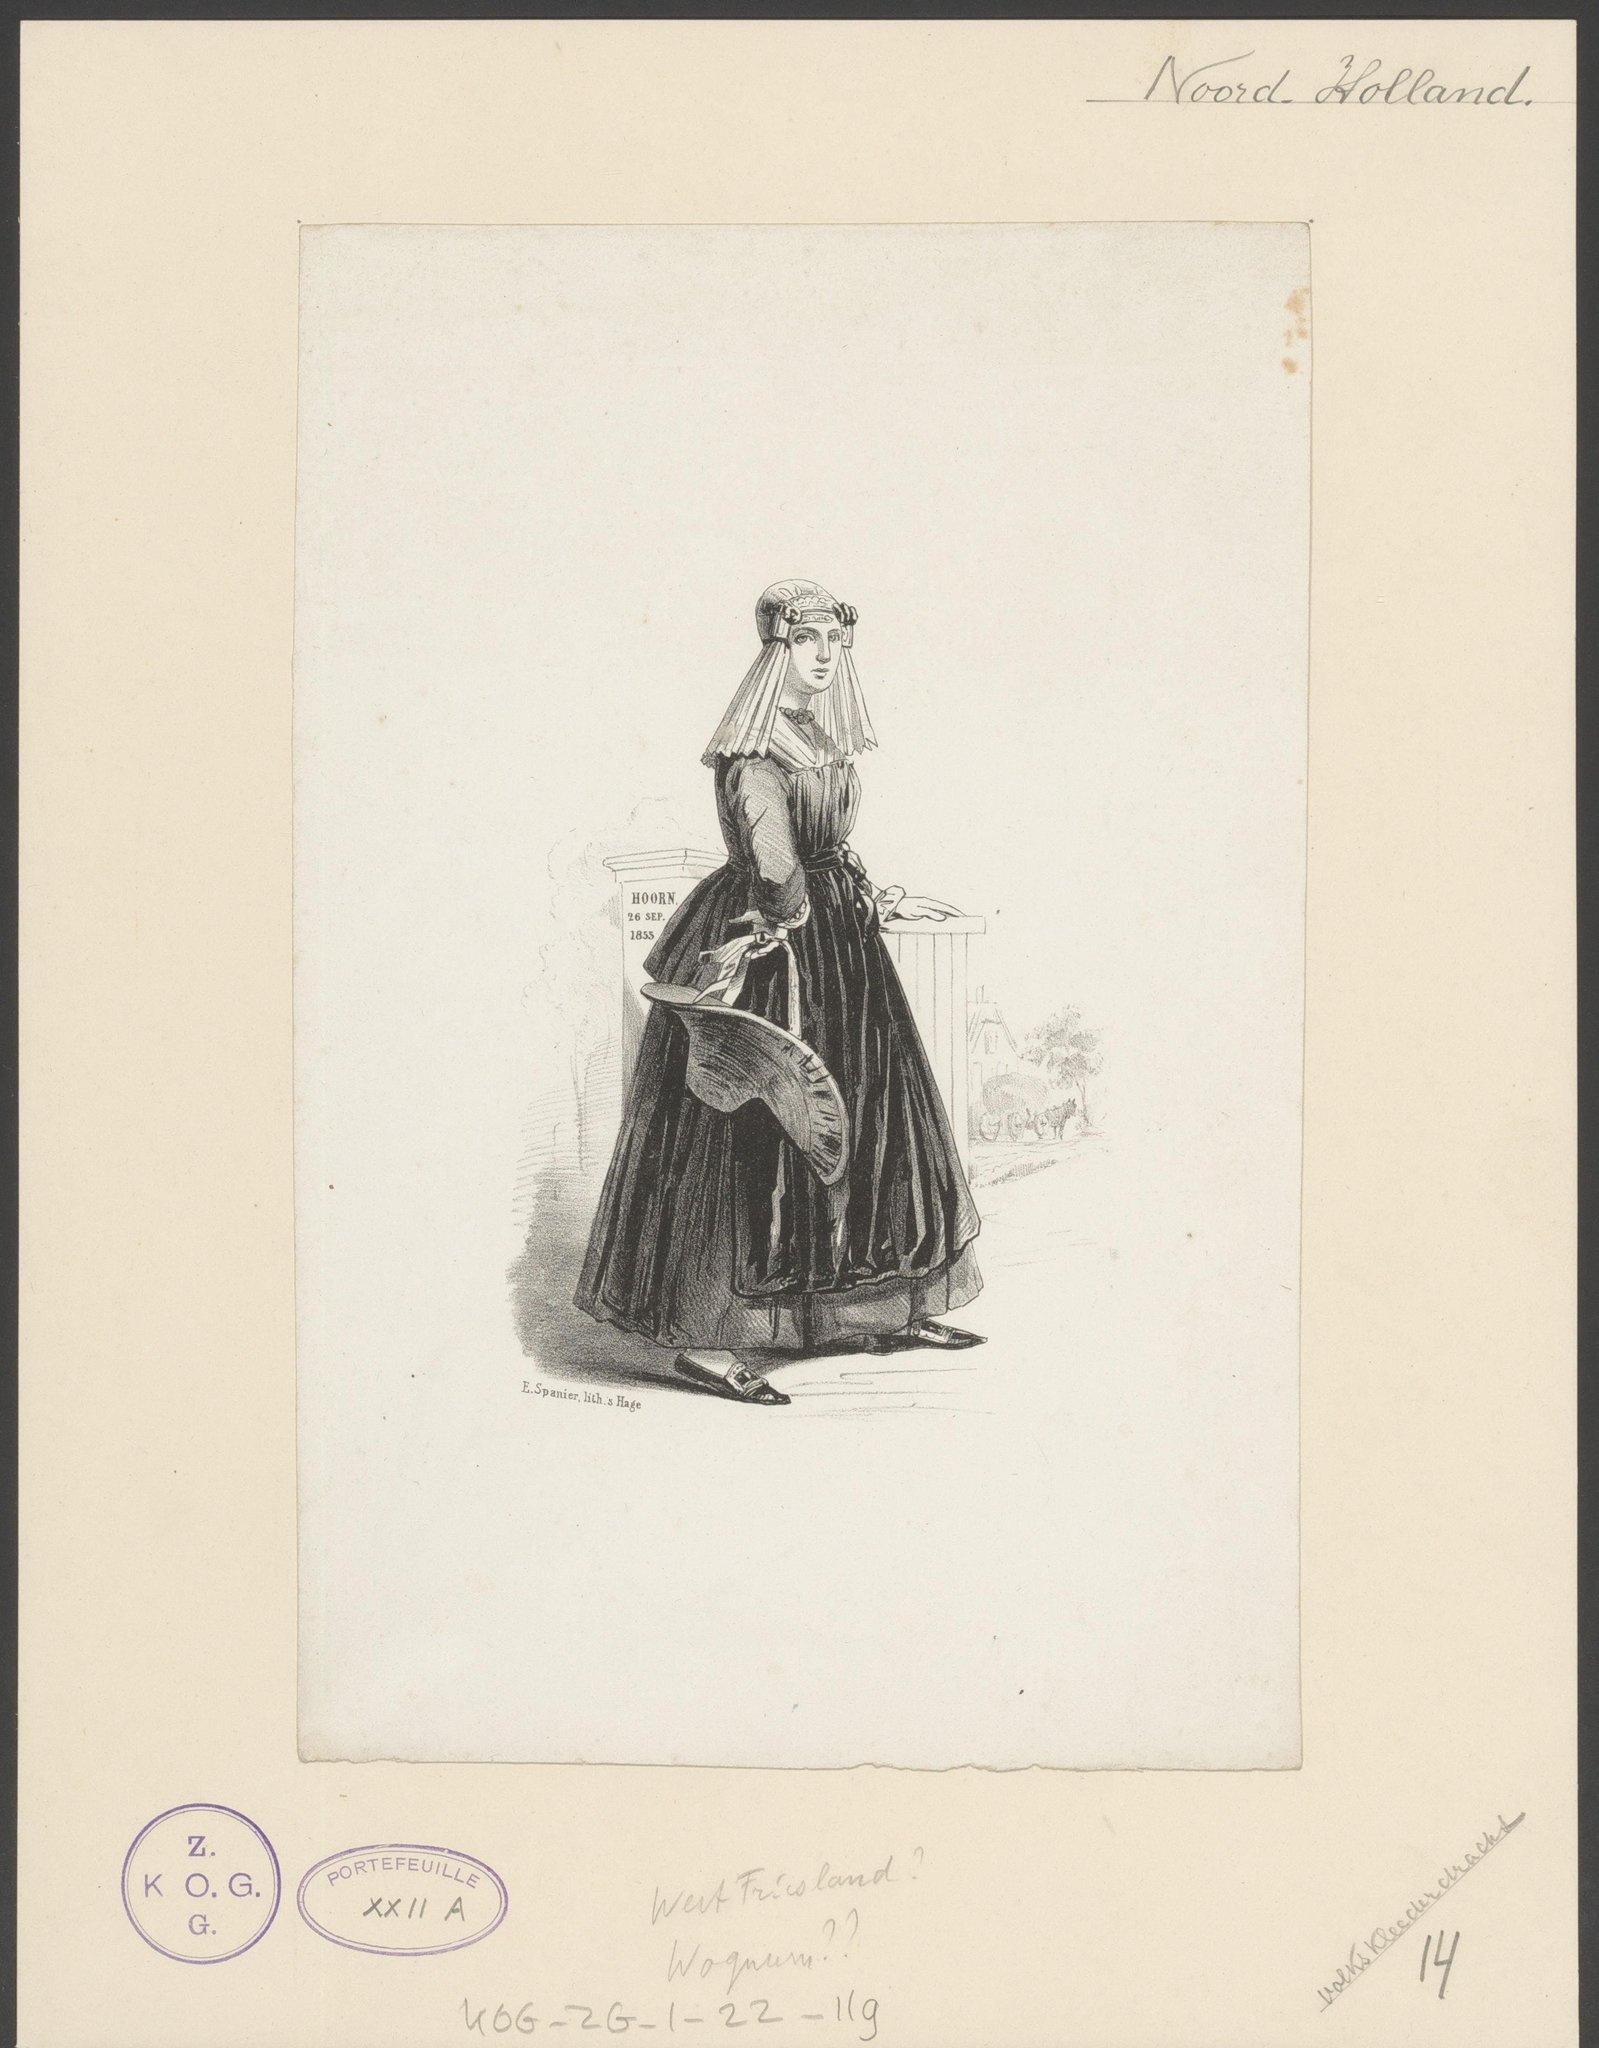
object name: print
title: Klederdracht van vrouw van Hoorn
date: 1855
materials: paper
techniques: lithograph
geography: netherlands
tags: head-gear (+ women's clothes), clothes, costume (+ women's clothes), folk costume, regional costume, hoorn (north holland)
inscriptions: collector's mark, collector's mark: Lugt 1641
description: Vrouw van Hoorn in klederdracht, met kap. Staande met de hoed in de hand. Onderwerpsrubrieken binnen de Atlas Zeden en Gewoonten: De Kleeding, Volkskleederdracht, Noord-Holland.